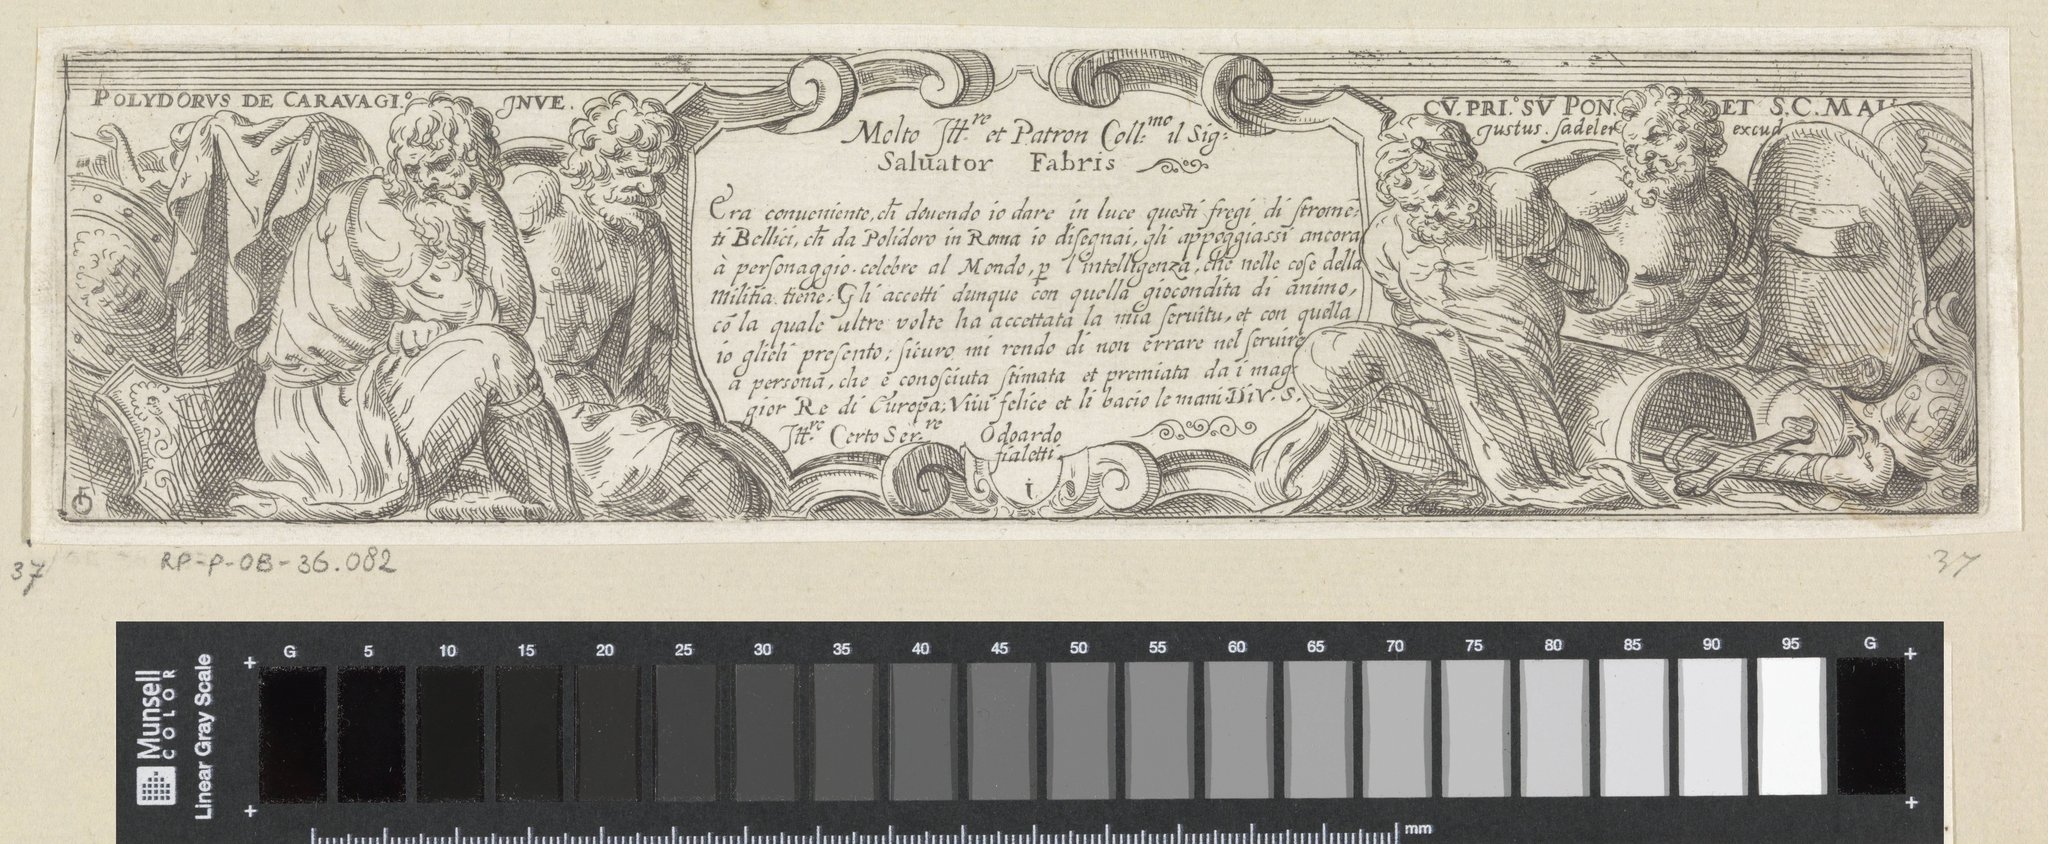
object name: print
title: Figuren tussen wapens en vazen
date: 1583-1638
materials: paper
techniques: etching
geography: italy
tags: sitting figure, weapons, slavery; serfs and enslaved persons, ornament ~ cartouche, prisoner of war (after the battle)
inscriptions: collector's mark: Lugt 240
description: Titelprent bij een reeks van vijf prenten.